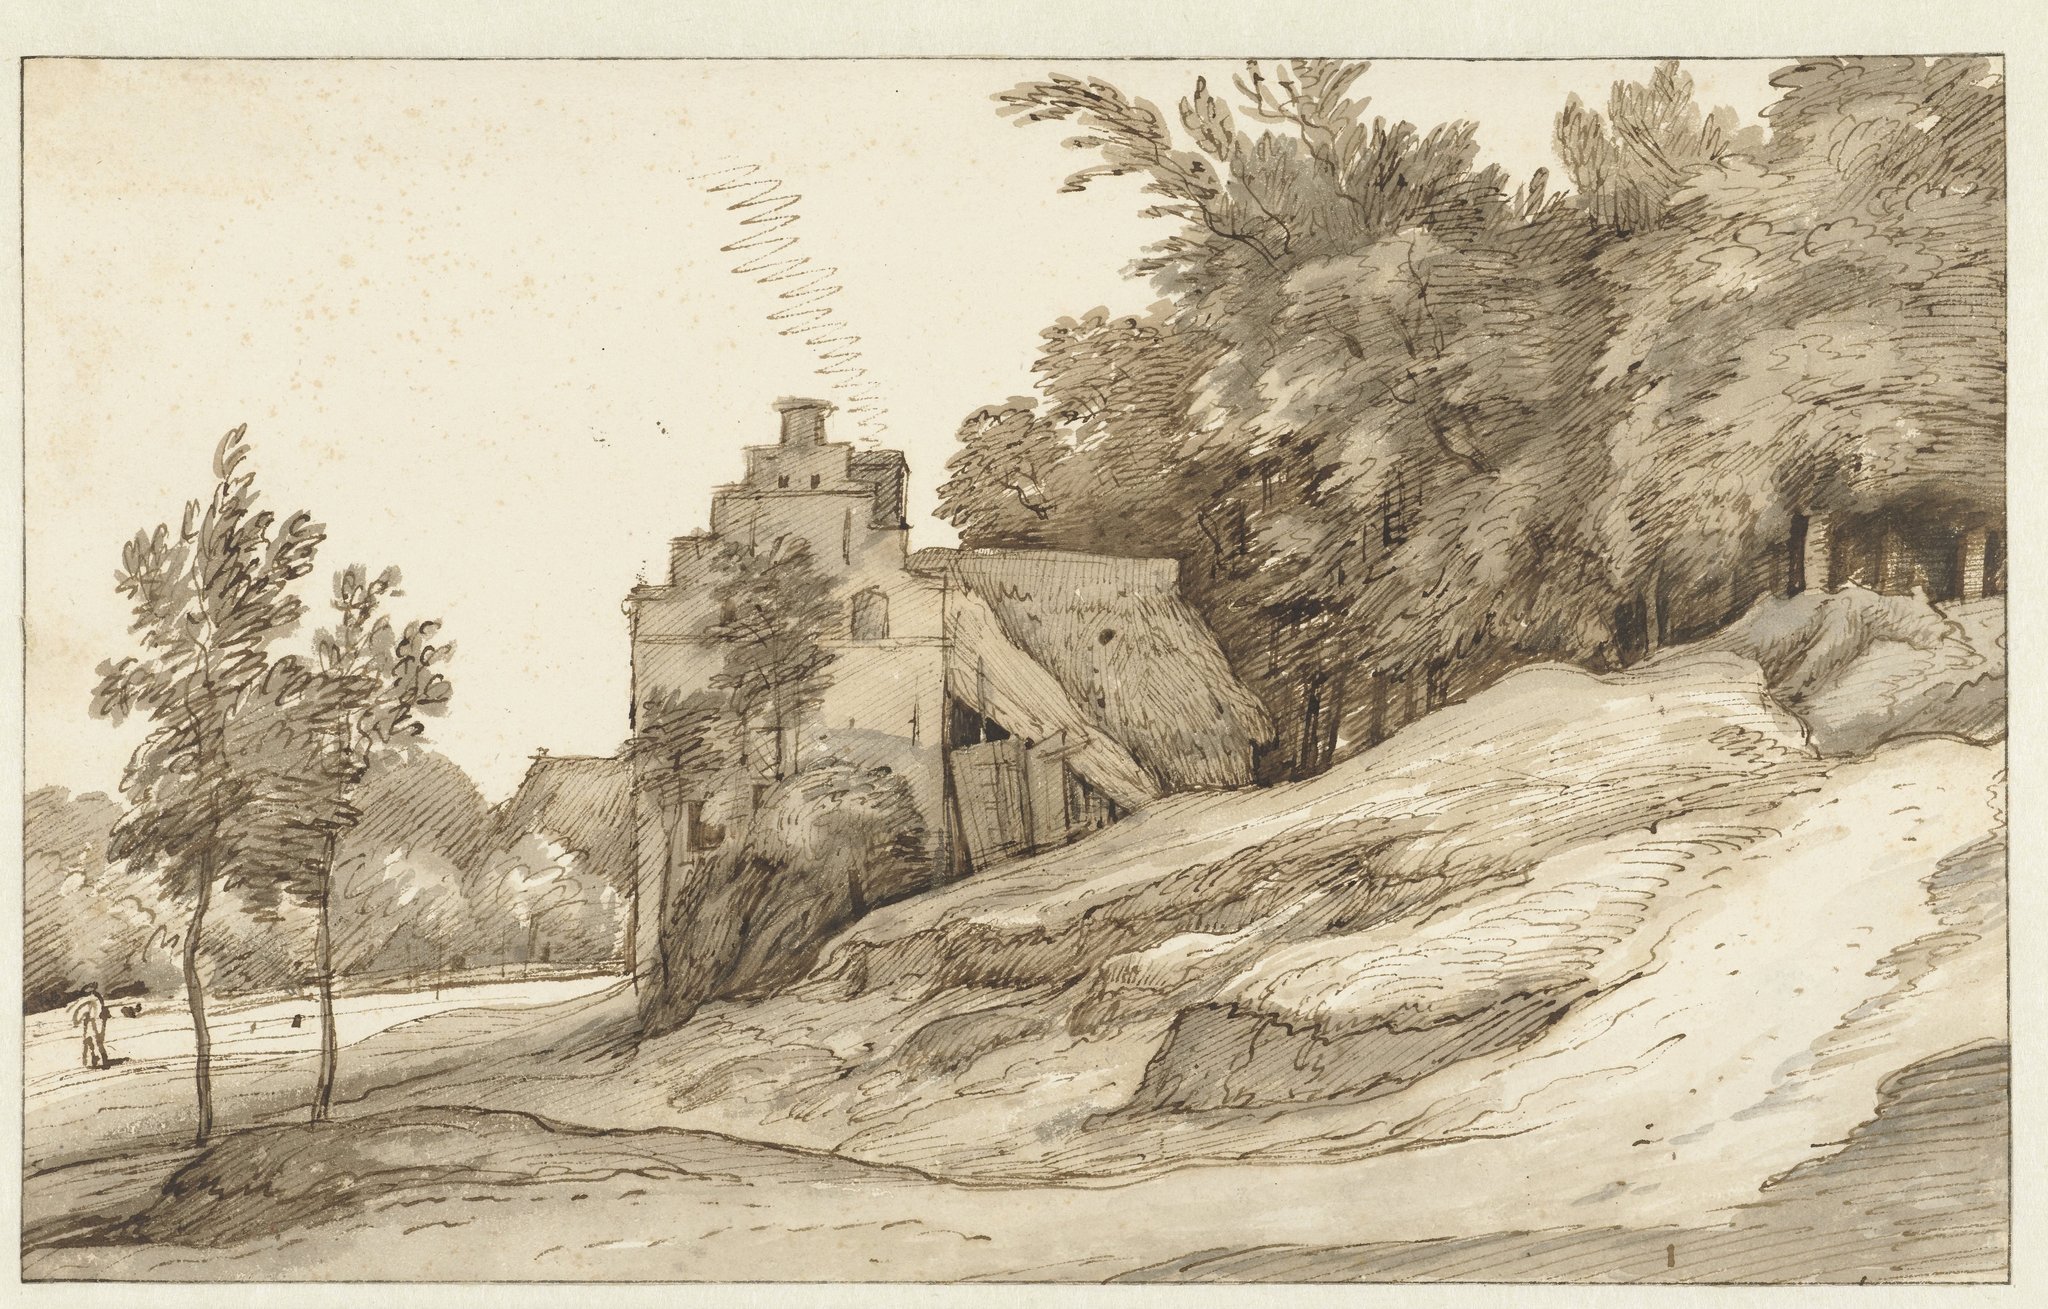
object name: drawing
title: Boerderij met trapgevel aan de rand van een bos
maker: jacob esselens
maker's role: draughtsman, print maker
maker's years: 1626-1687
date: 1636-1687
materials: ink, paper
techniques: brush, pen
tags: farm or solitary house in landscape, arnhem